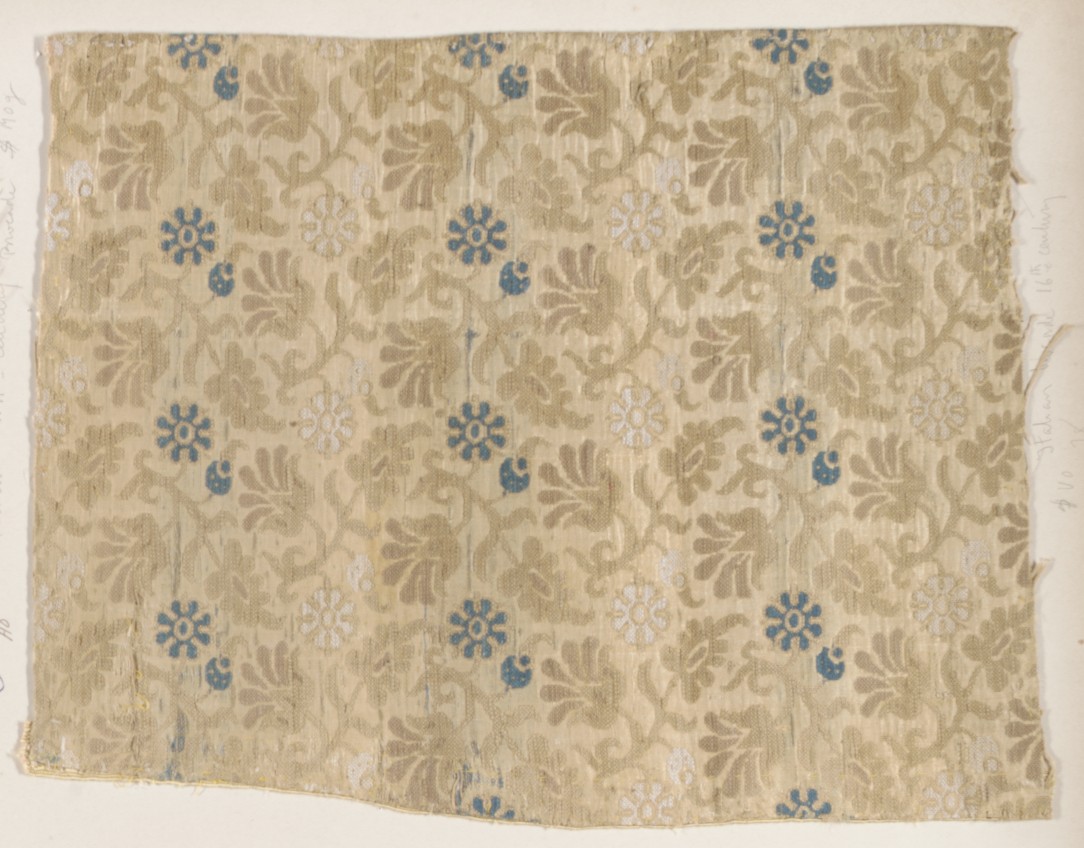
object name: fragment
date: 1501-1600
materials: silk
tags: flowers,leaves